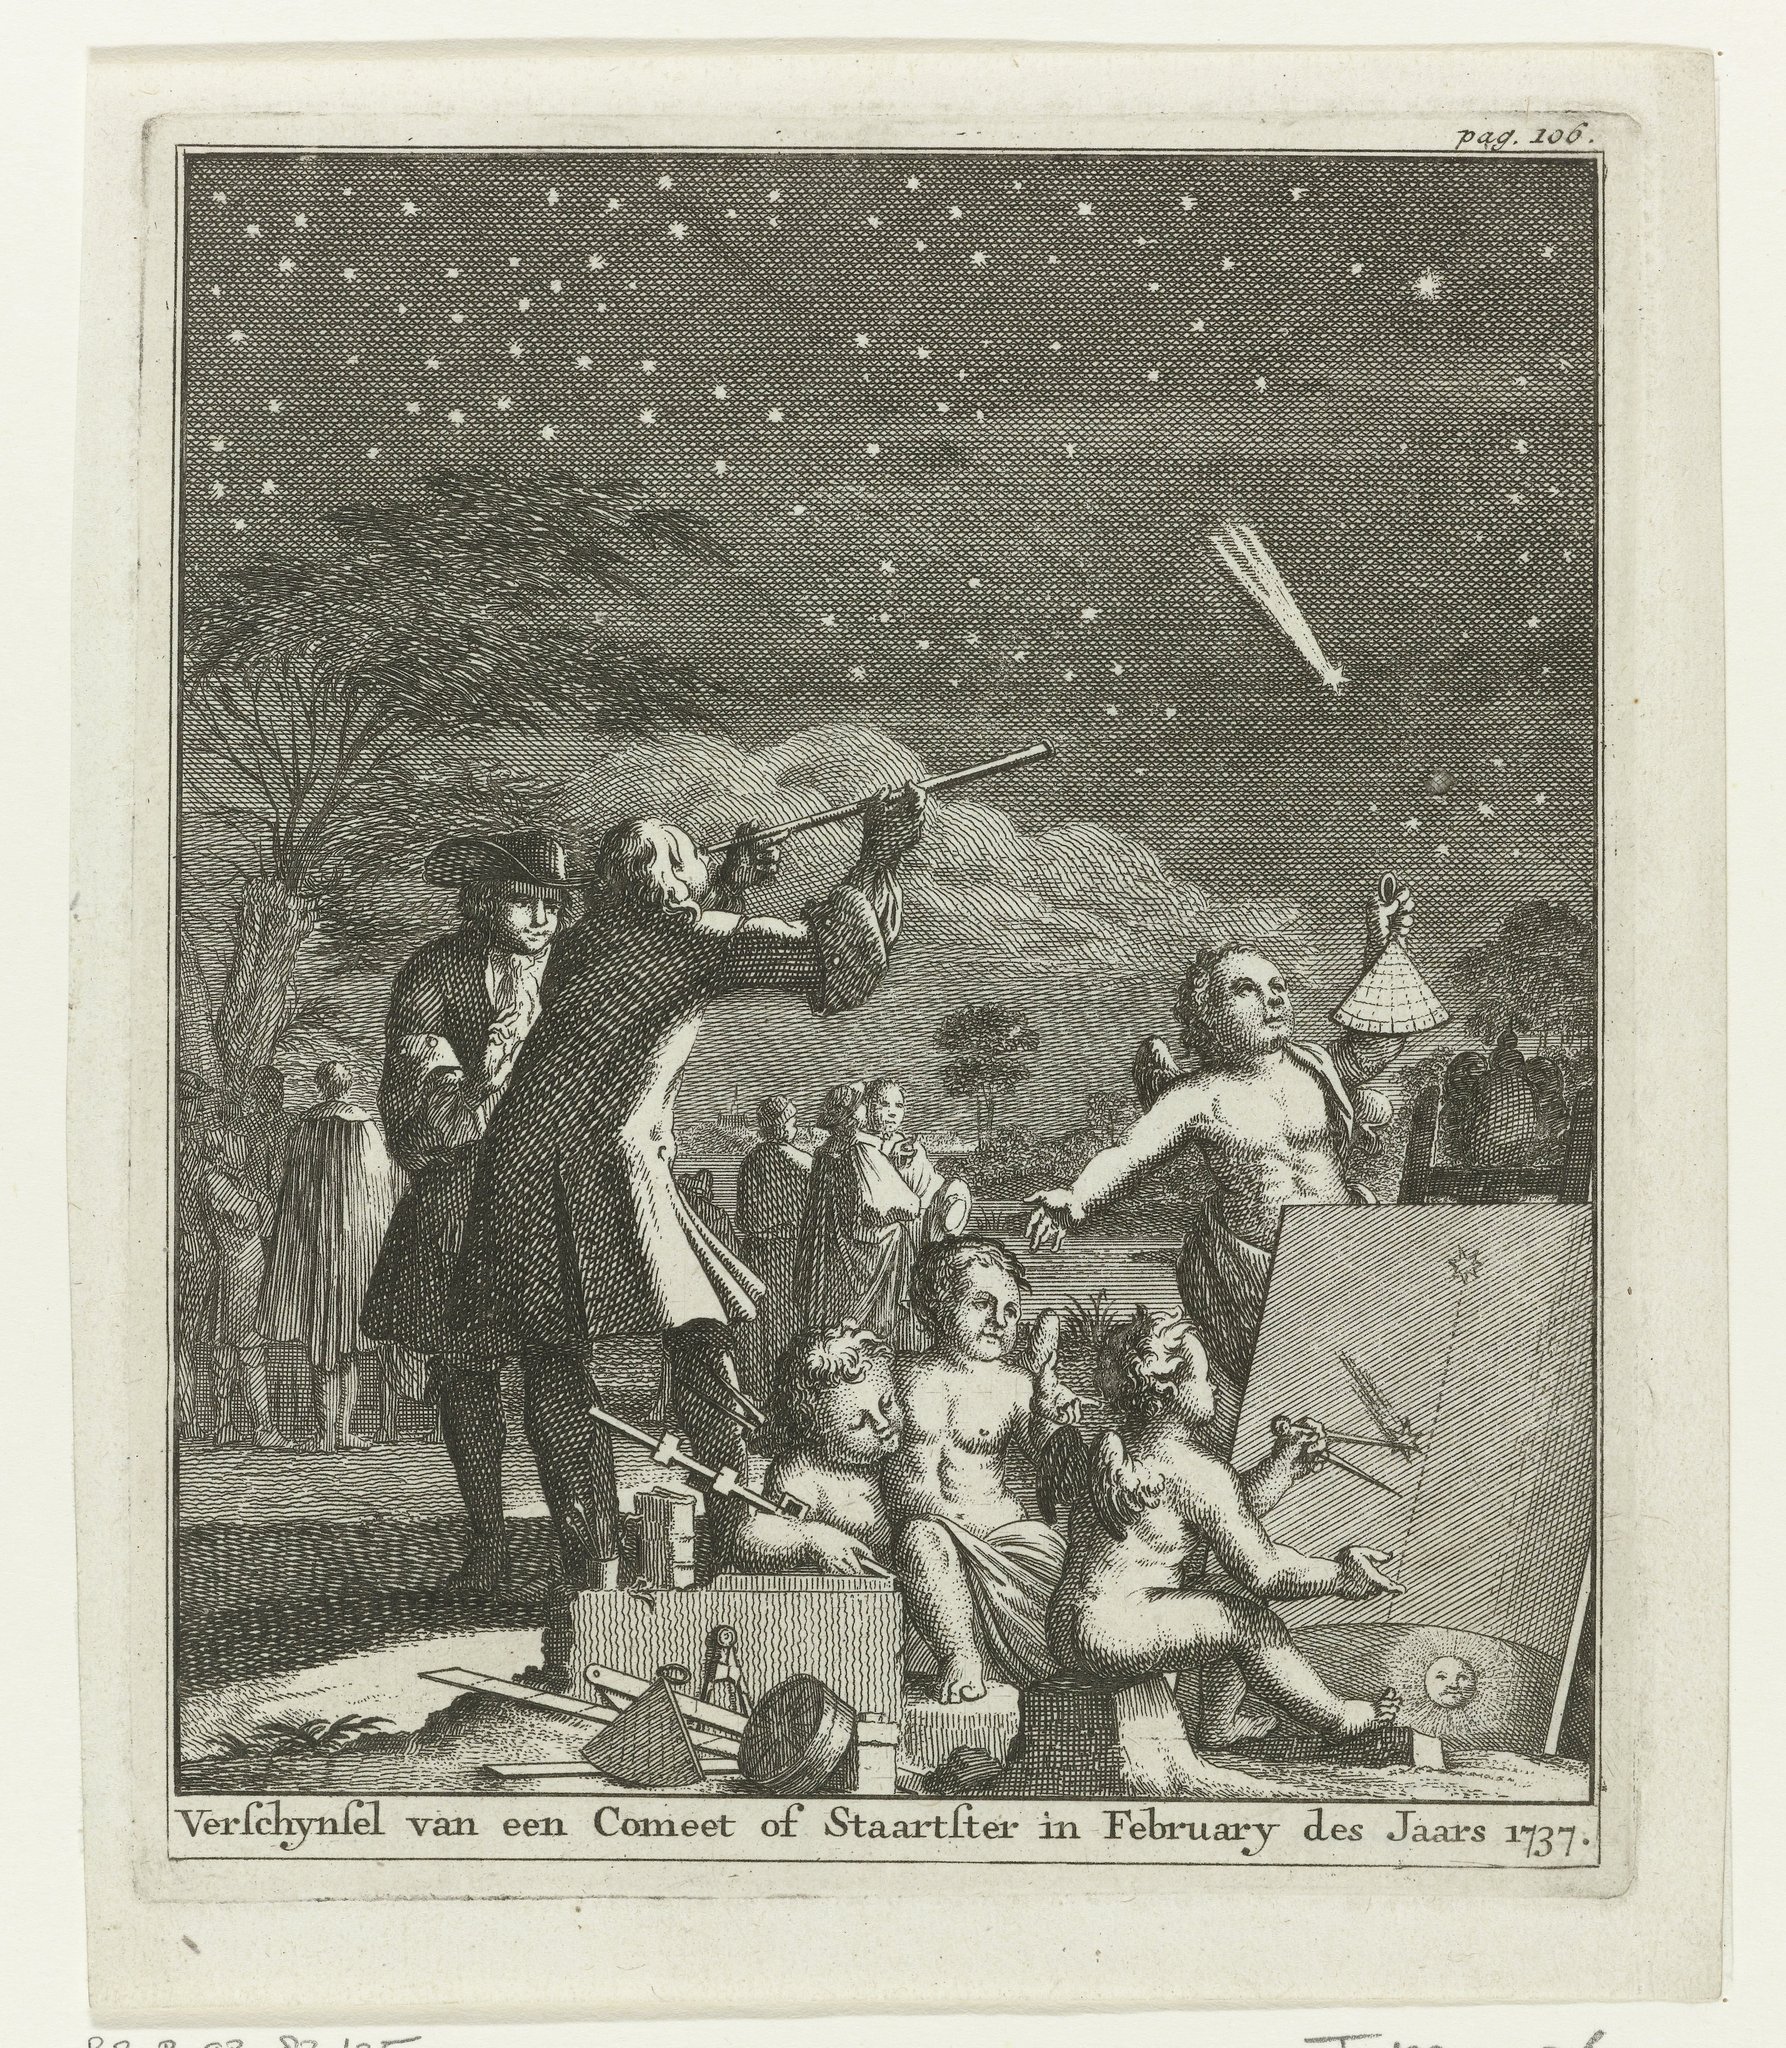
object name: print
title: Verschynsel van een Comeet of Staartster in February des Jaars 1737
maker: Anonymous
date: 1737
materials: paper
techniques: etching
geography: northern netherlands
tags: comet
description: De komeet (Swift-Tuttle) zichtbaar in februari 1737 boven Nederlands. Geleerden bestuderen met een telescoop de komeet aan de nachtelijke hemel, op de voorgrond putti in de weer met astronomische instrumenten. Gemerkt rechtsboven pag. 106.